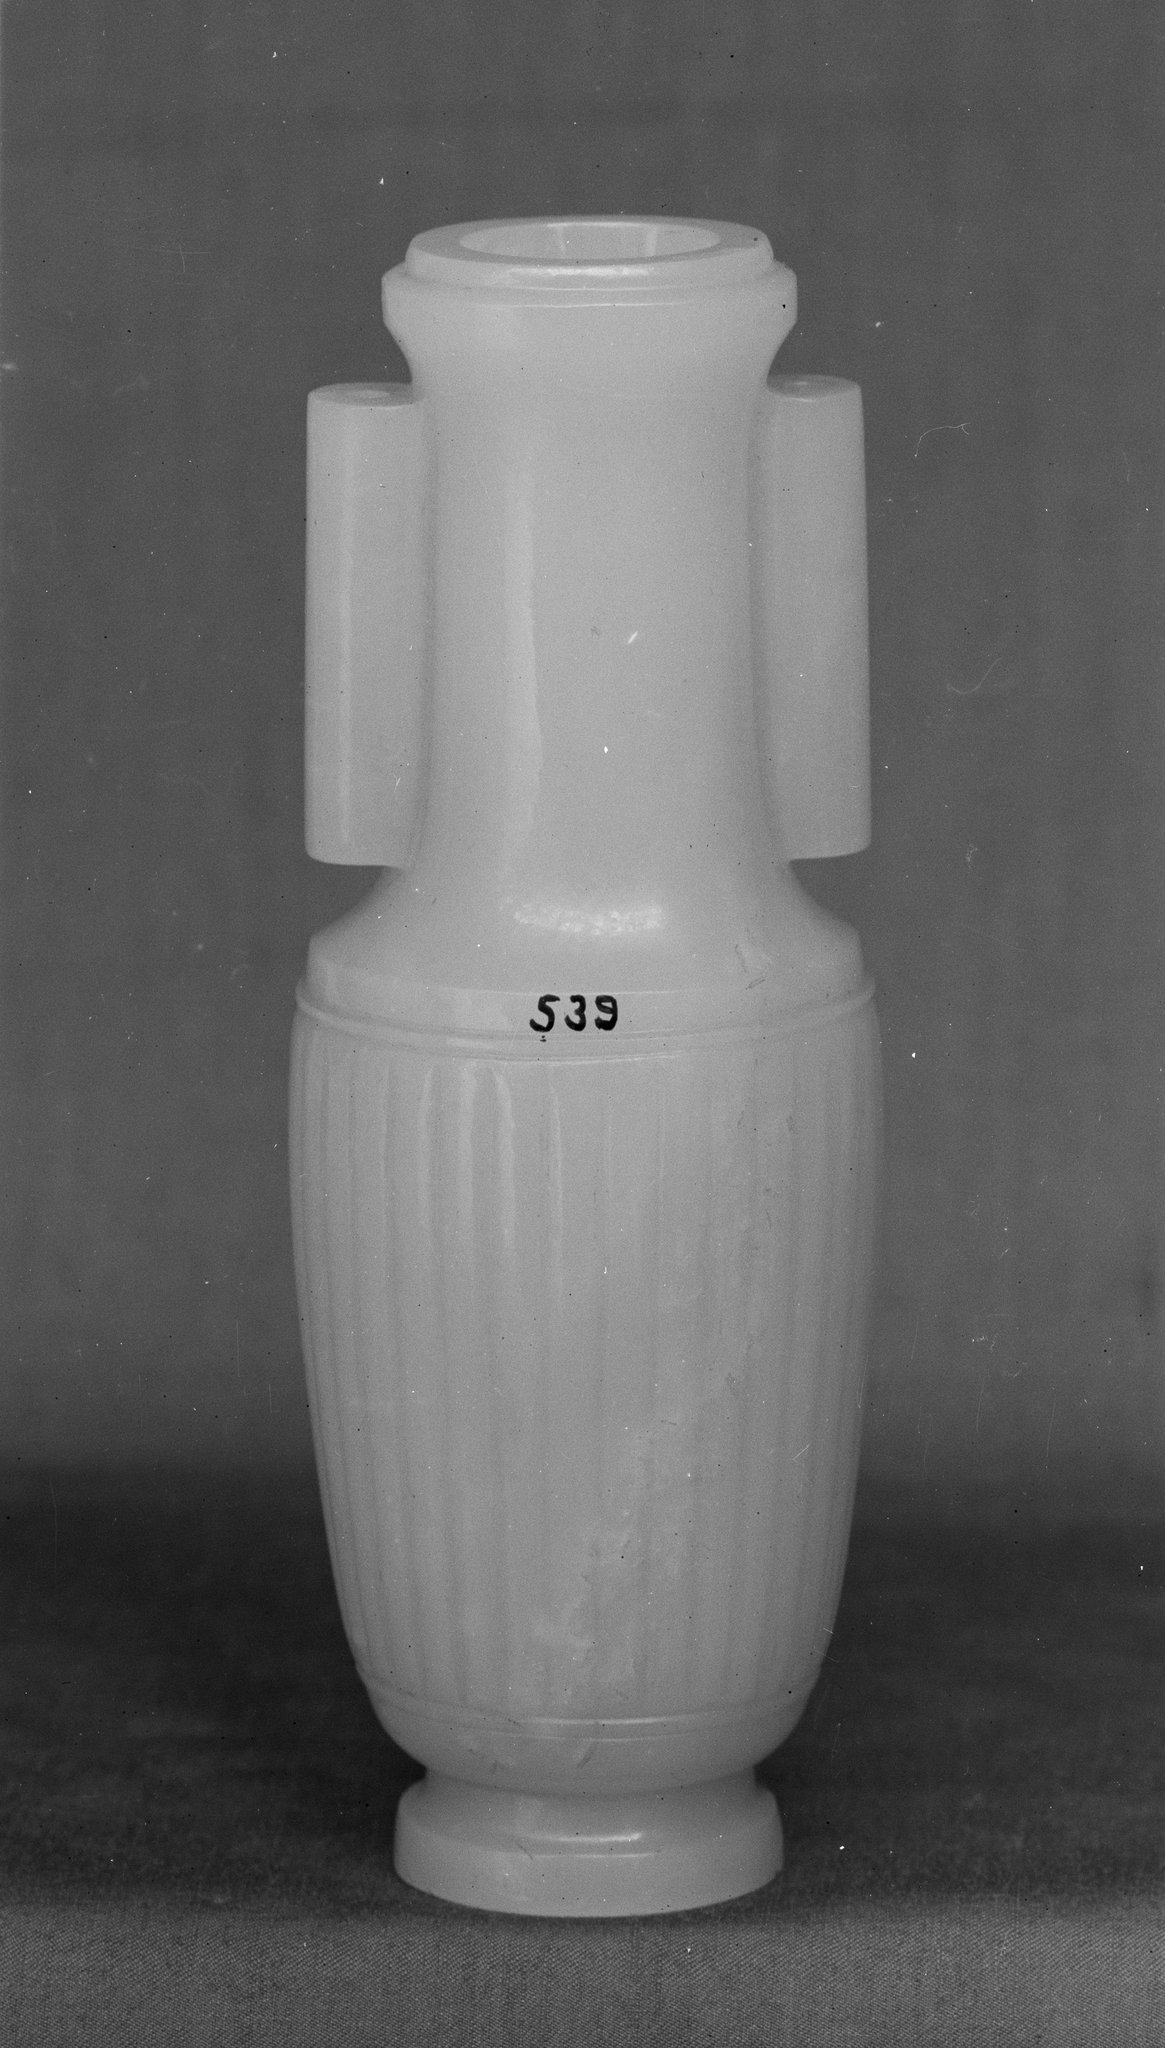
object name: vase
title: Vase from an incense set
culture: chinese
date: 1701-1800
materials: jade